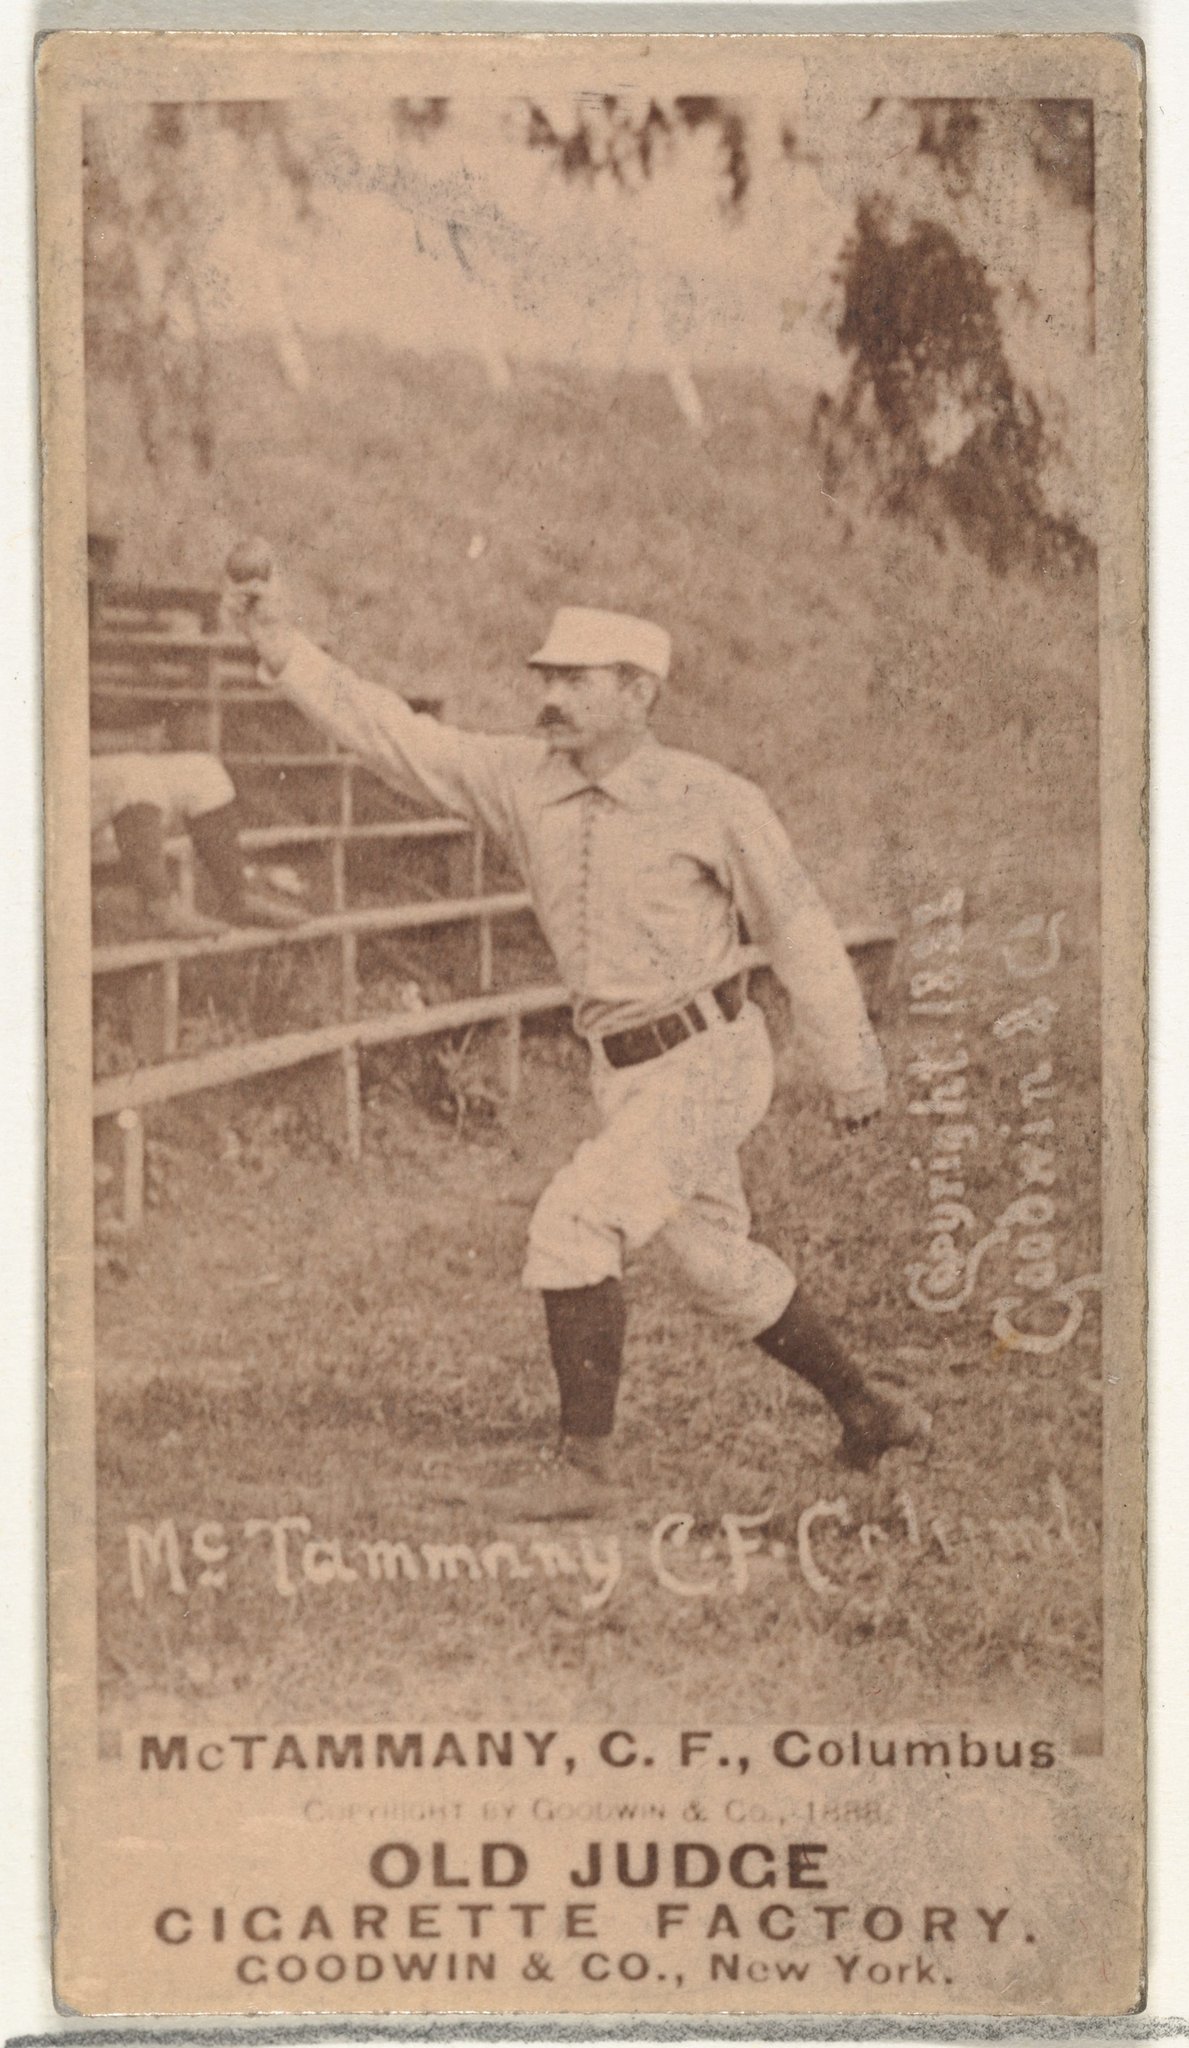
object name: baseball card, photograph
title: James Edward "Jim" McTamany, Center Field, Cleveland, from the Old Judge series (N172) for Old Judge Cigarettes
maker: goodwin & company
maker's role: publisher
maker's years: 1850-1950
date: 1888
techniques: albumen silver print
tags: men,portraits,baseball,athletes